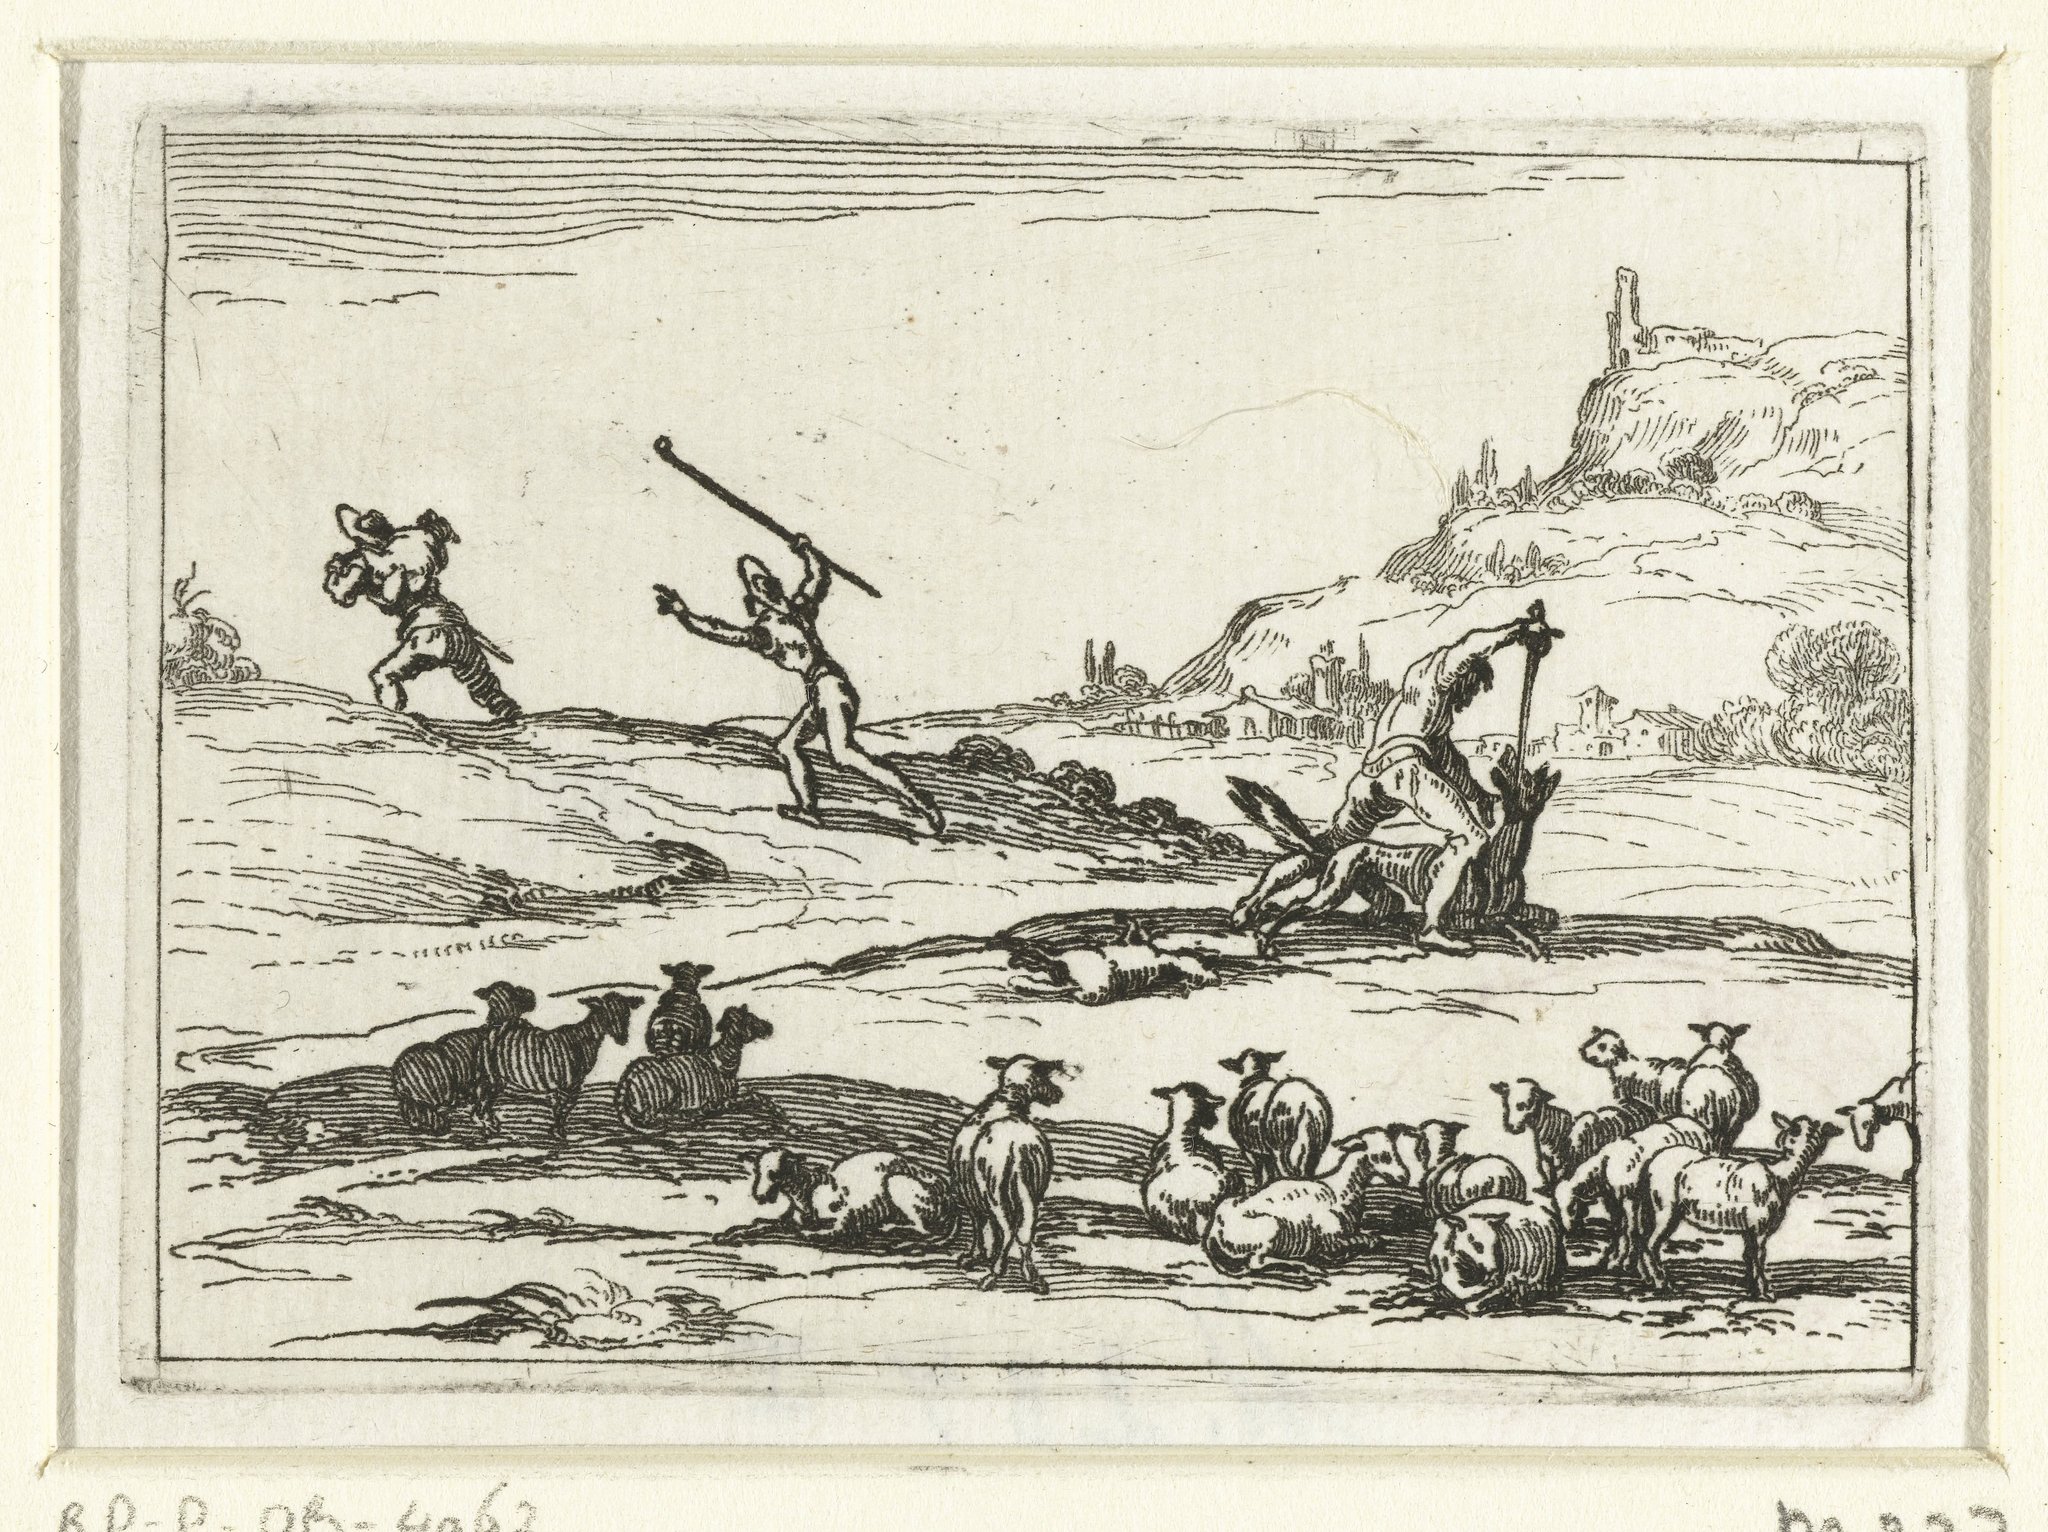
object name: cognizance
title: Herders verdedigen hun kudde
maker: jacques callot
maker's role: draughtsman, print maker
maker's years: 1592-1635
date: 1621-1635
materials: paper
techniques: etching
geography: nancy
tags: herding, herdsman, herdswoman, shepherd, shepherdess, cowherd, etc., thief, herd, flock, beasts of prey, predatory animals: wolf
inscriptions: collector's mark: Lugt 240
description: Voorstelling van twee herders die hun kudde schapen met hand en tand verdedigen: de een doodt een wolf, de ander achtervolgt een dief. Dit blad is onderdeel van de embleemserie 'Kloosterleven in emblemen'. De tweede staat van deze serie behelst naast een geïllustreerde titelpagina en 26 emblemen nog een titelpagina en een blad met opdracht, beide in boekdruk zonder afbeelding.